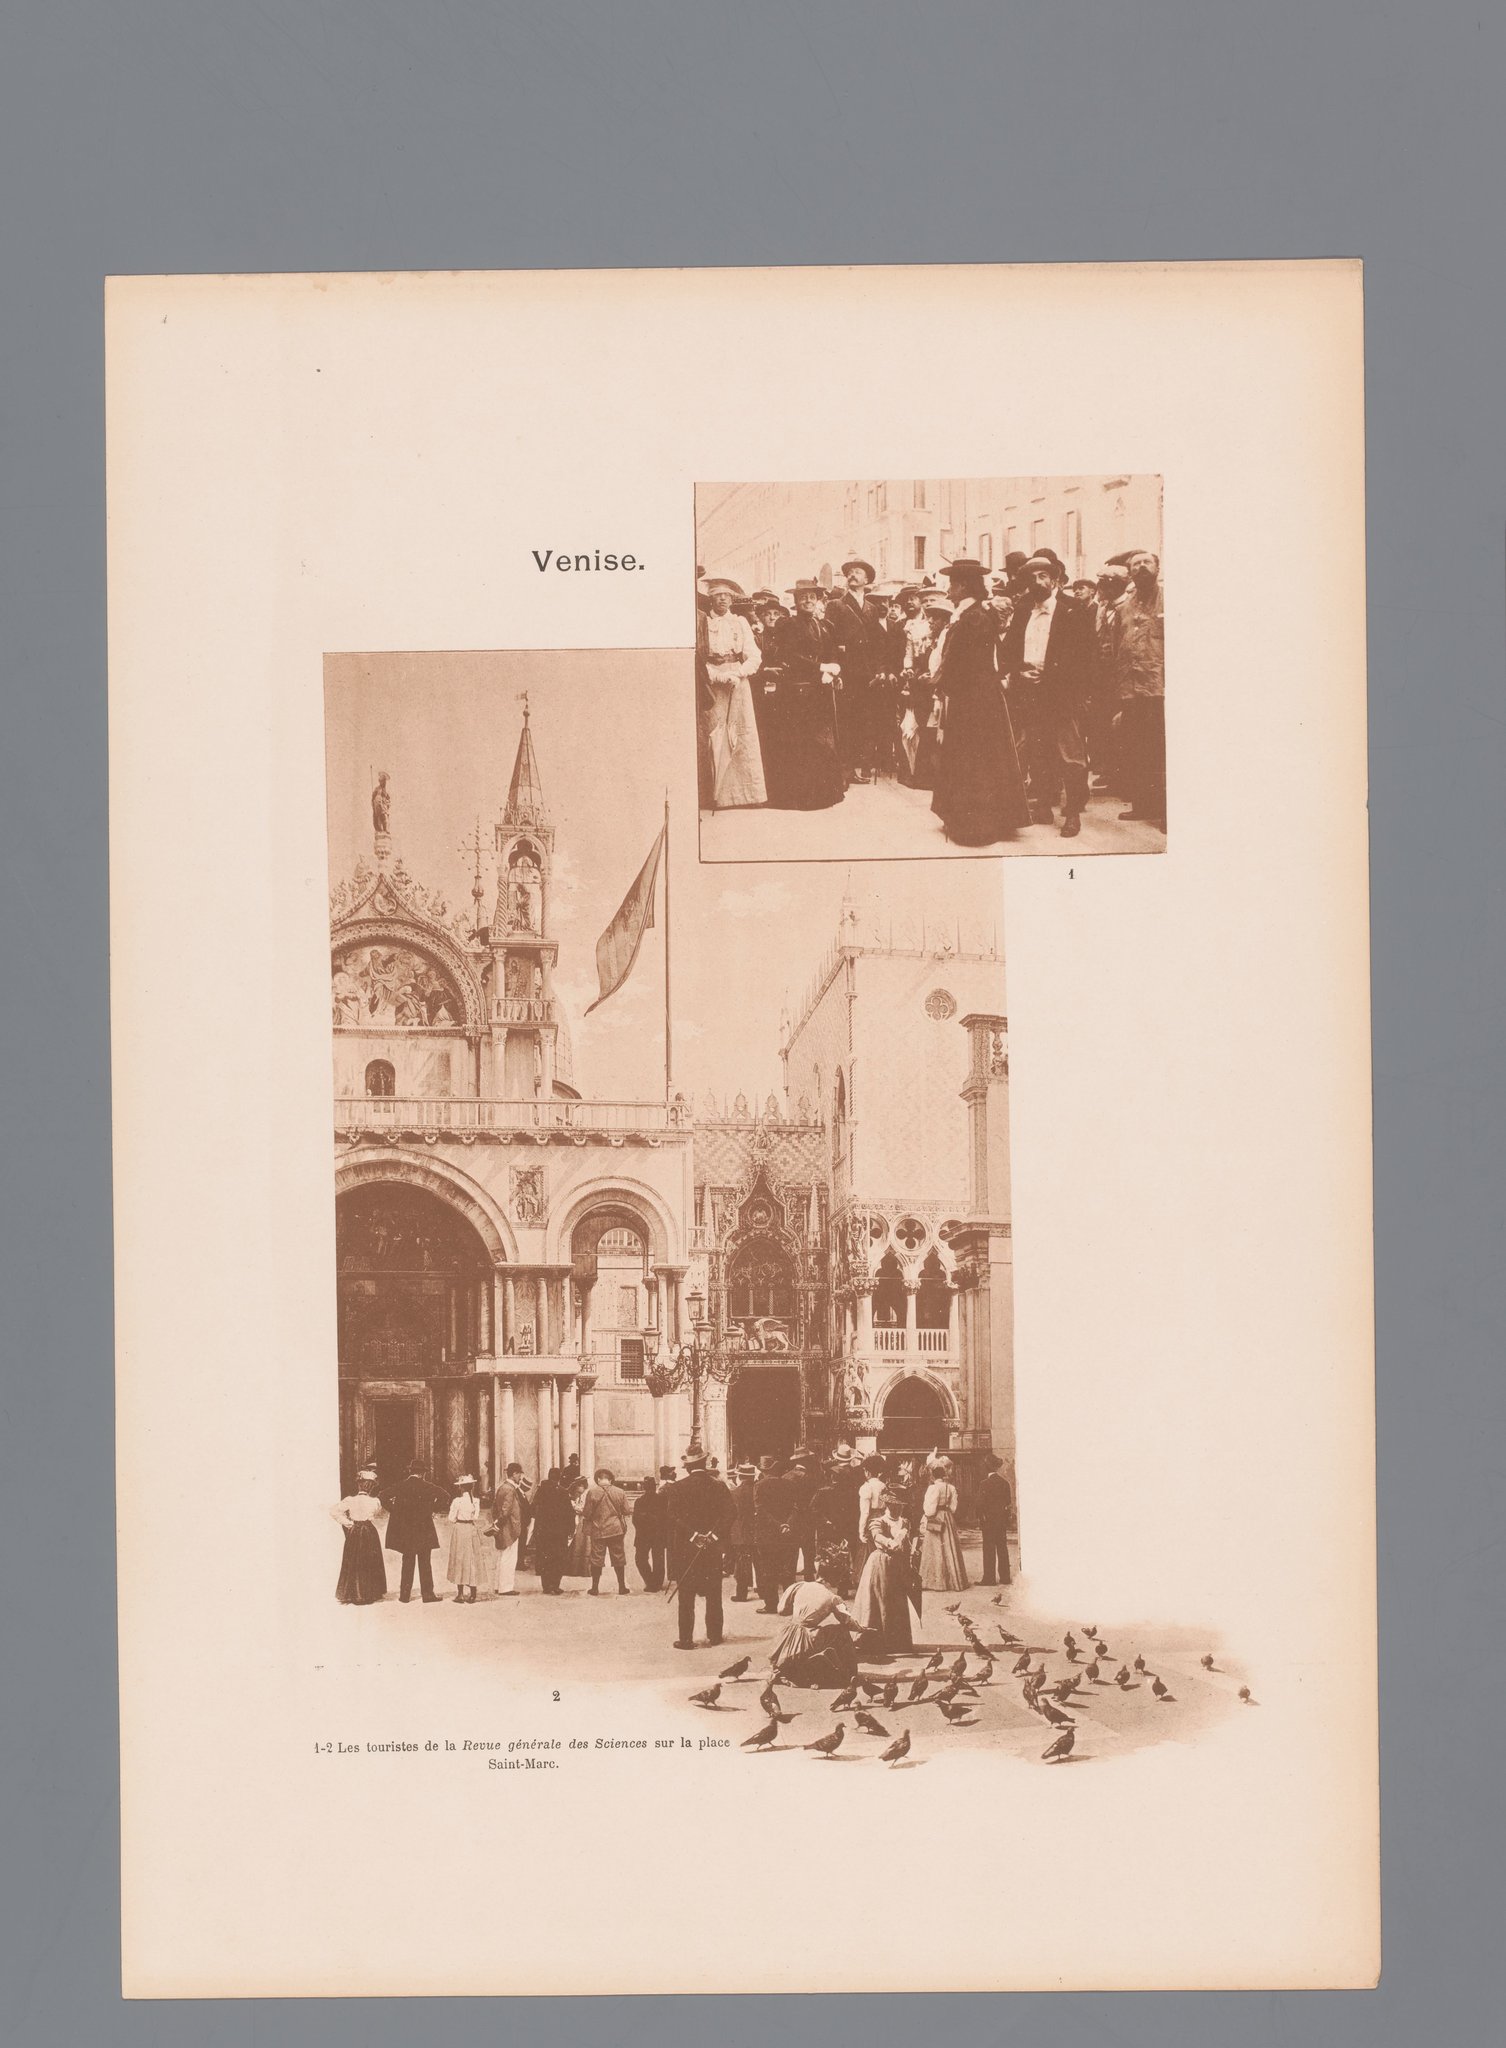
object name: photomechanical print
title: Twee afbeeldingen van de groep toeristen van de Revue générale des Sciences op het San Marcoplein in Venetië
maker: Anonymous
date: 1893-1898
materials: paper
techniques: photograph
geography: venice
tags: square, place, circus, etc., adult woman (+ more than eight persons), adult man (+ more than eight persons)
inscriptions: inscription: ‘1-2 Les touristes de la Revue générale des Sciences sur la place/ Saint-Marc.’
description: Deze prenten maken deel uit van een omslag met 103 prenten op 16 bladen en een titelblad.